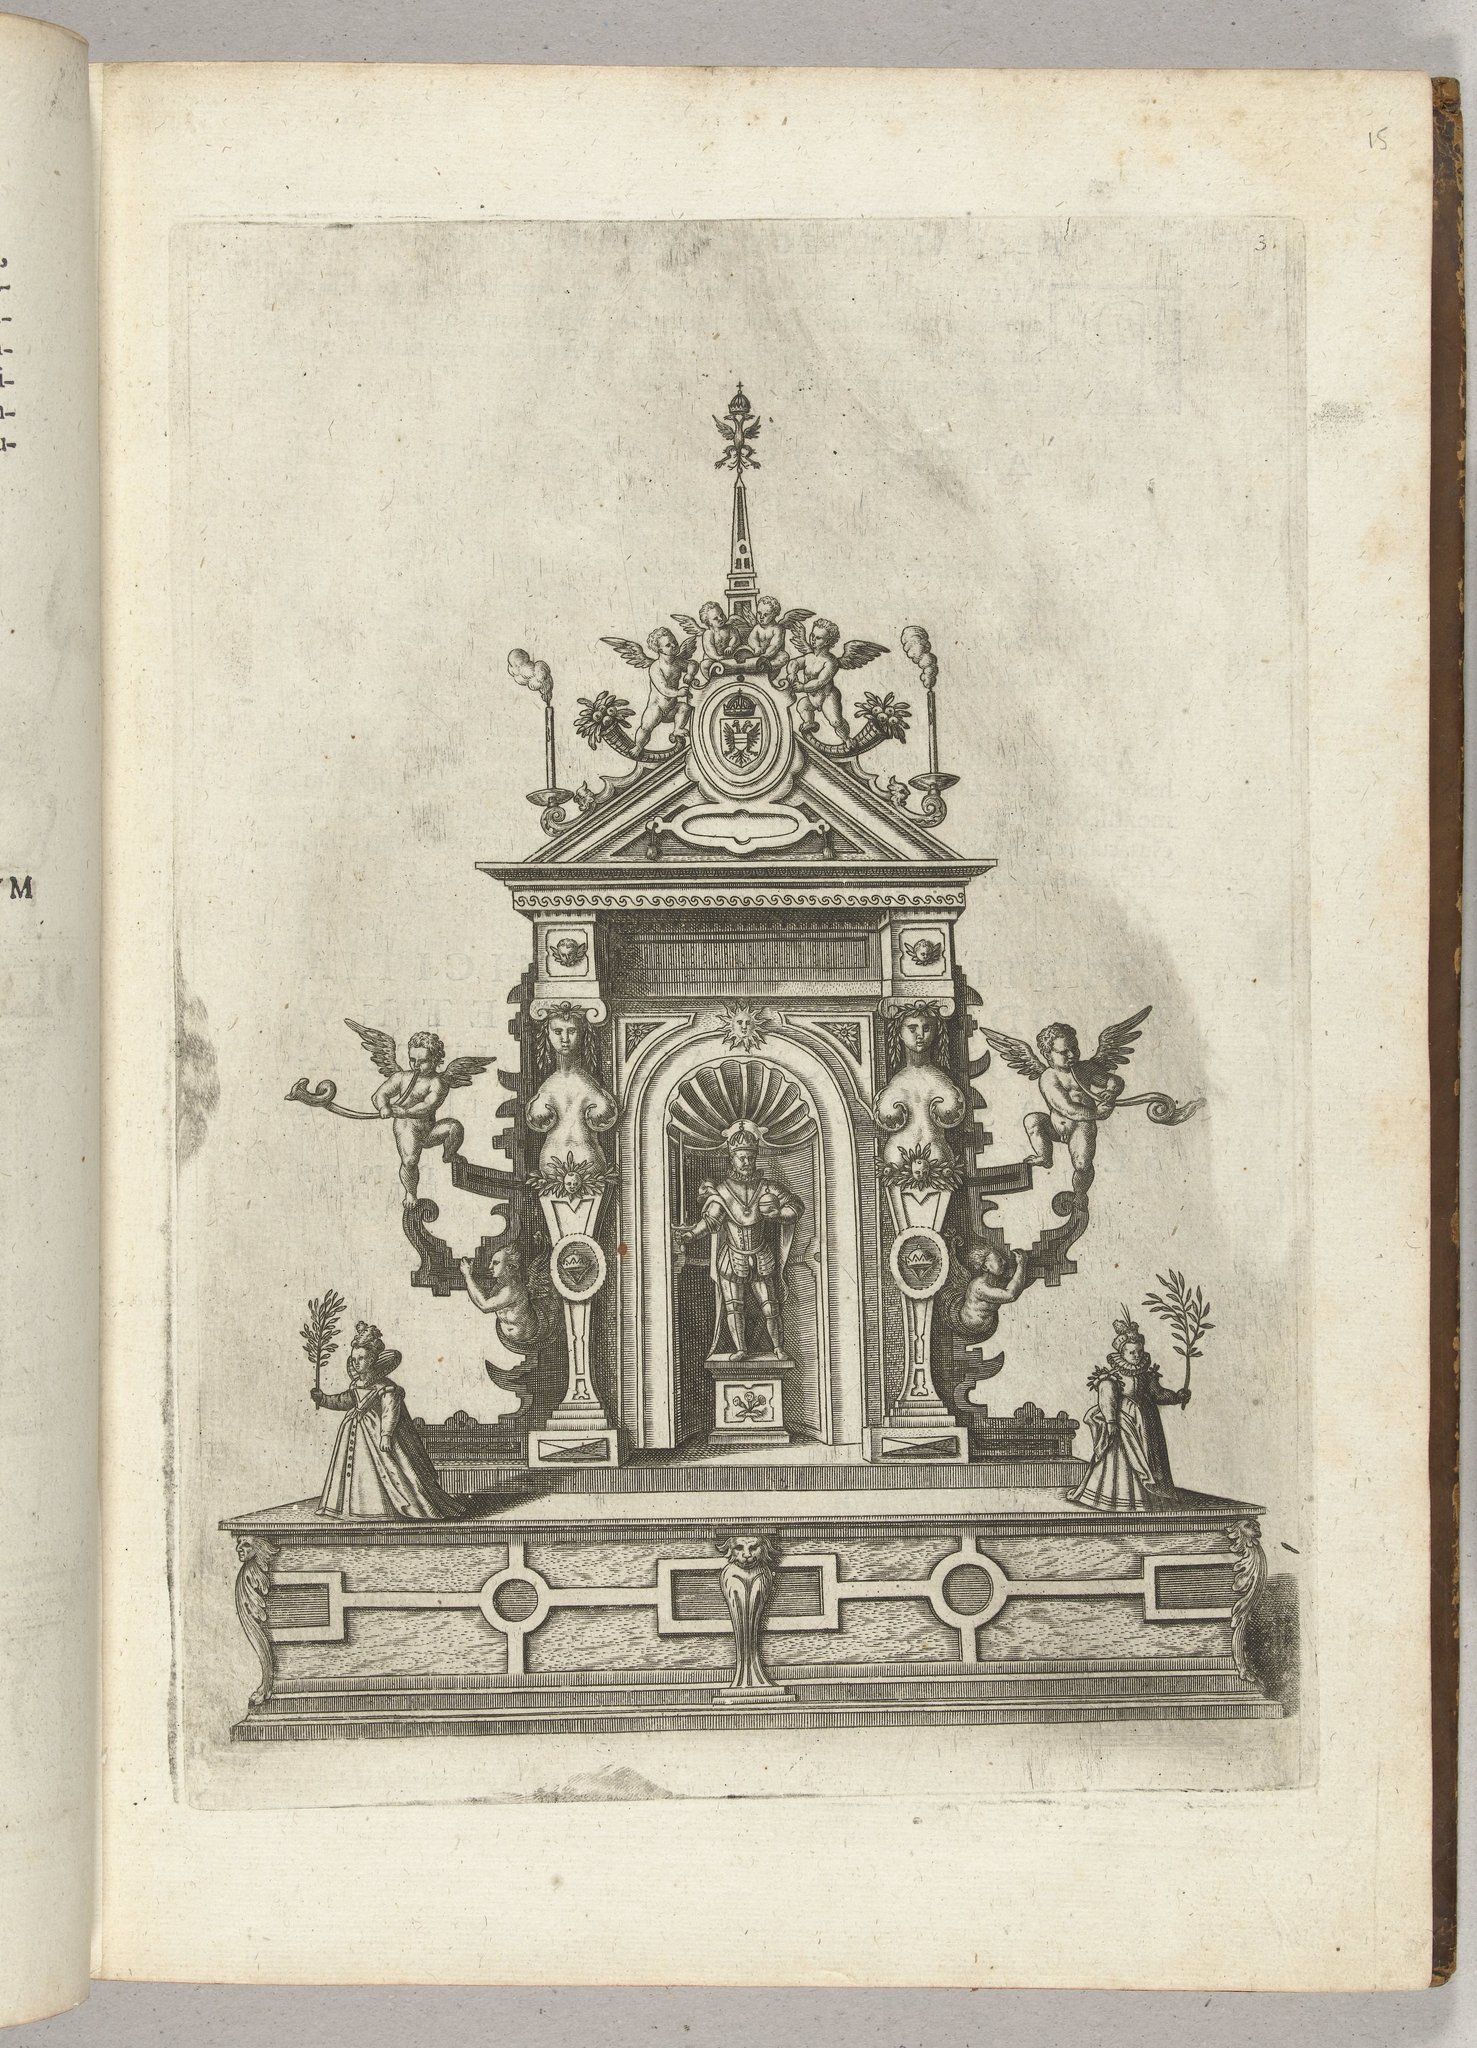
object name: print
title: Toneel met hertog Frederik I, 1594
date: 1594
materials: paper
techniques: engraving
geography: southern netherlands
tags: vienna, triumphal entry and public reception, pageant, 'entrée solennelle', 'joyeuse entrée', brussels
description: Toneel met de hertog Frederik I in 1314. Feestelijke intocht van aartshertog Ernst als gouverneur der Nederlanden gehouden te Brussel op 30 januari 1594. Onderdeel van de beschrijving van deze intocht Descriptio et explicatio pegmatum, arcuum spectaculorum quae Bruxellae Brabant. pridie Cal. Febr. Ao. 1594 exhibita fuere, sub ingressum ... Ernesti ... Archiducis Austriae ... pro Philippo II. Belgicae ditionis gubernatore, J. Mommaert, Brussel 1594. Genummerd: 3.